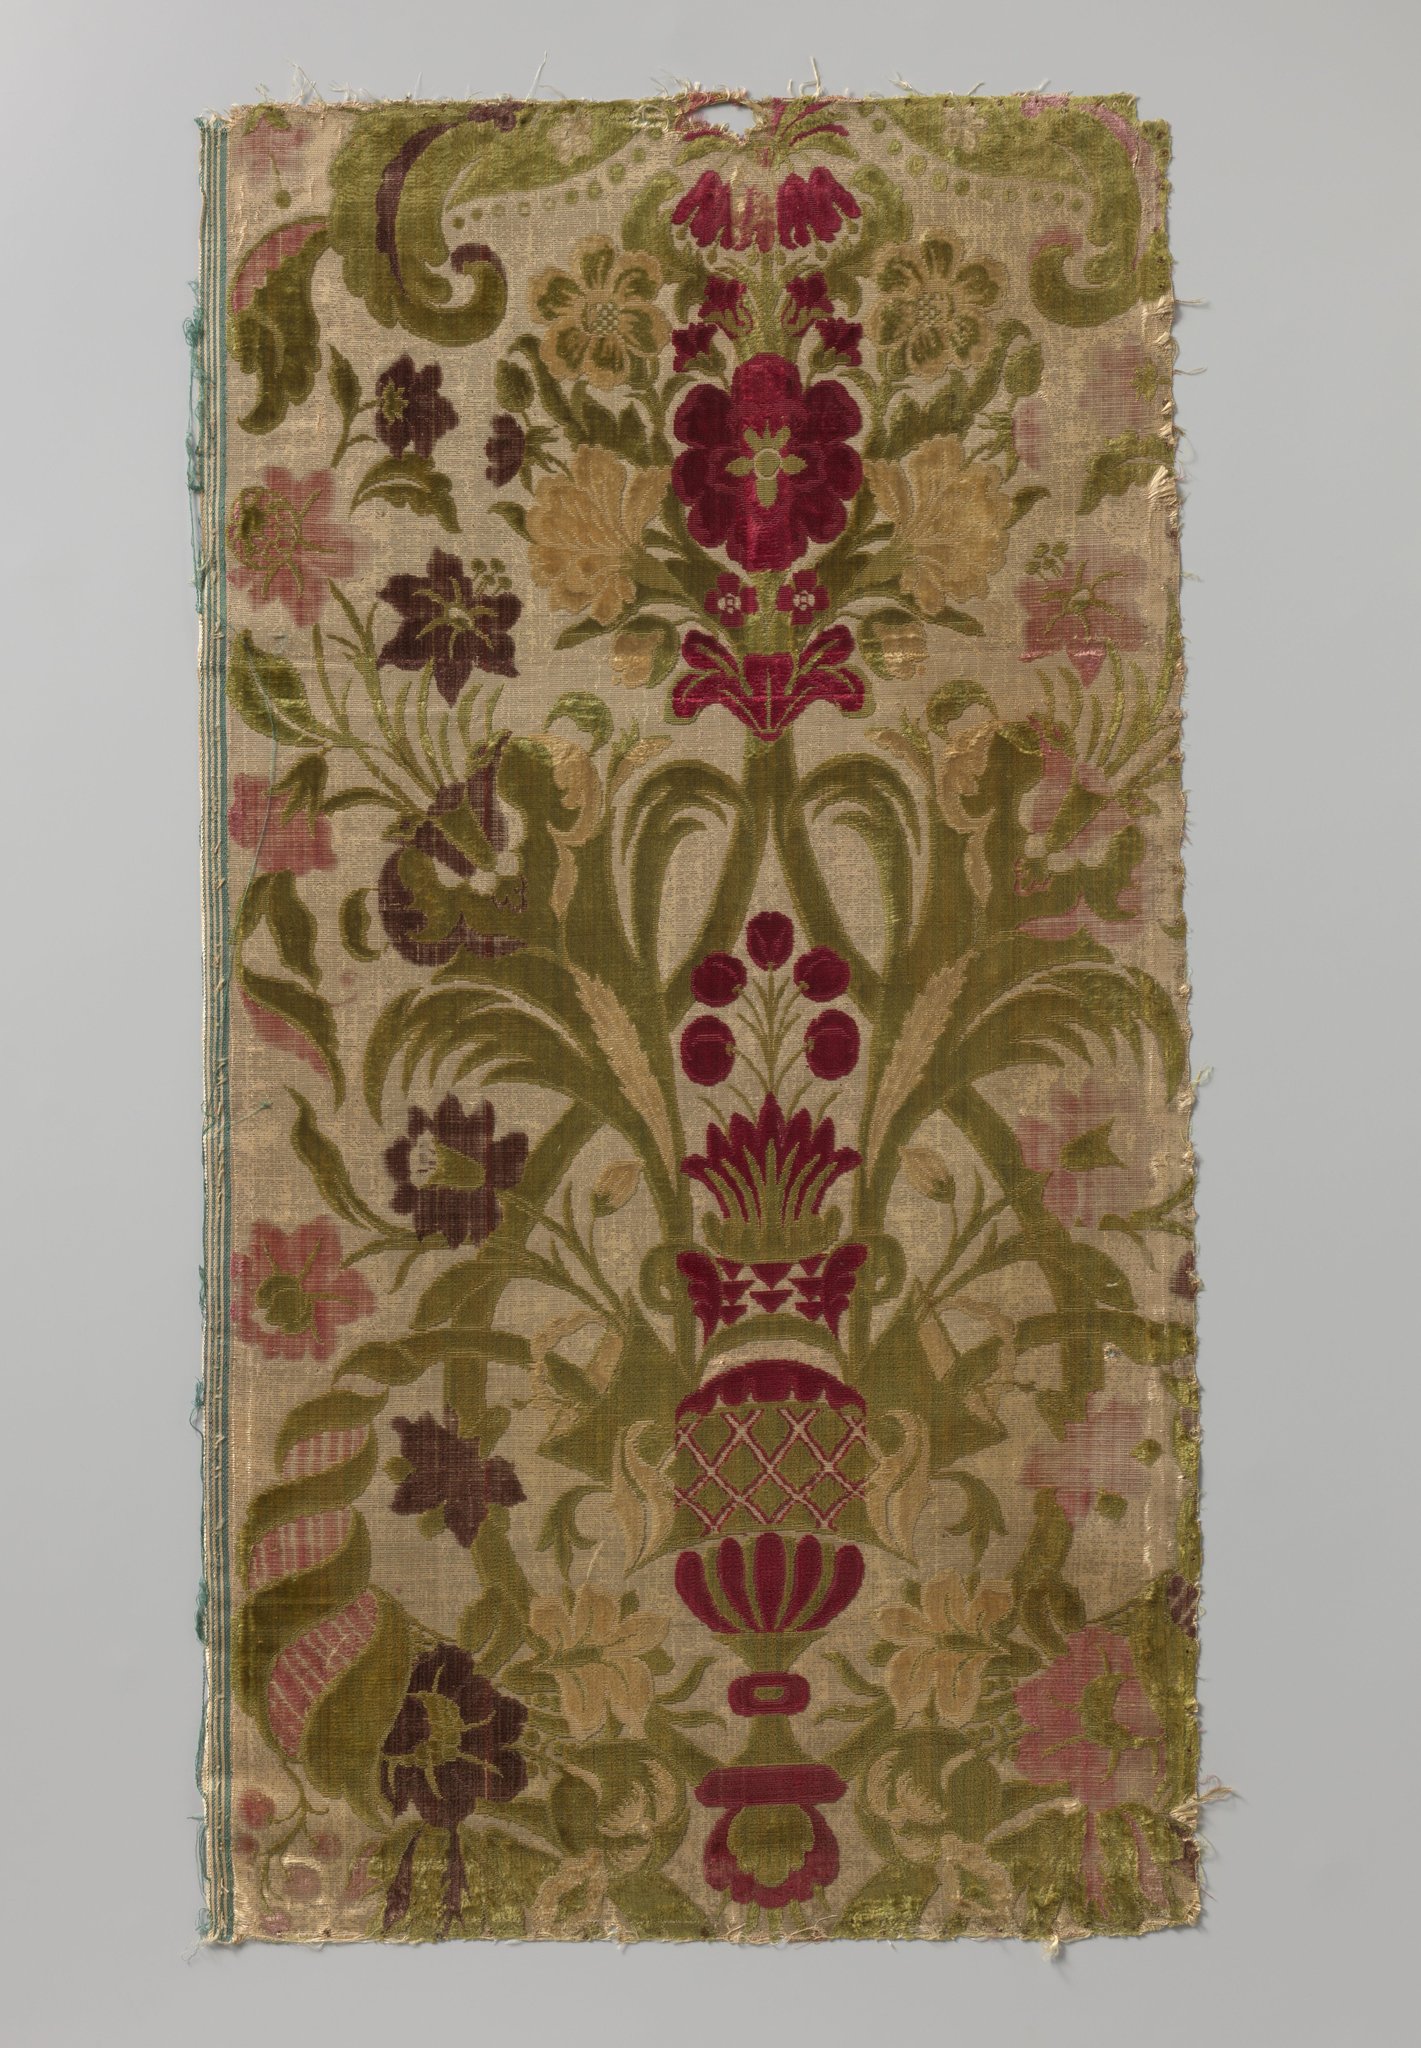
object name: fragment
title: Baan van veelkleurig ciseléfluweel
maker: Anonymous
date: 1675-1699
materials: silk, velvet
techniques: velvet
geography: genoa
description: Baan veelkleurig zijdefluweel met ongeschoren pool. Symmetrisch patroon van een vaas in ojiefvorm met bloem- en bladranken en twee hoorns van overvloed. Boven de vaas een rozet met bloemen en acanthusranken. Kleuren: groen, roze, rood, wijnrood en brons.